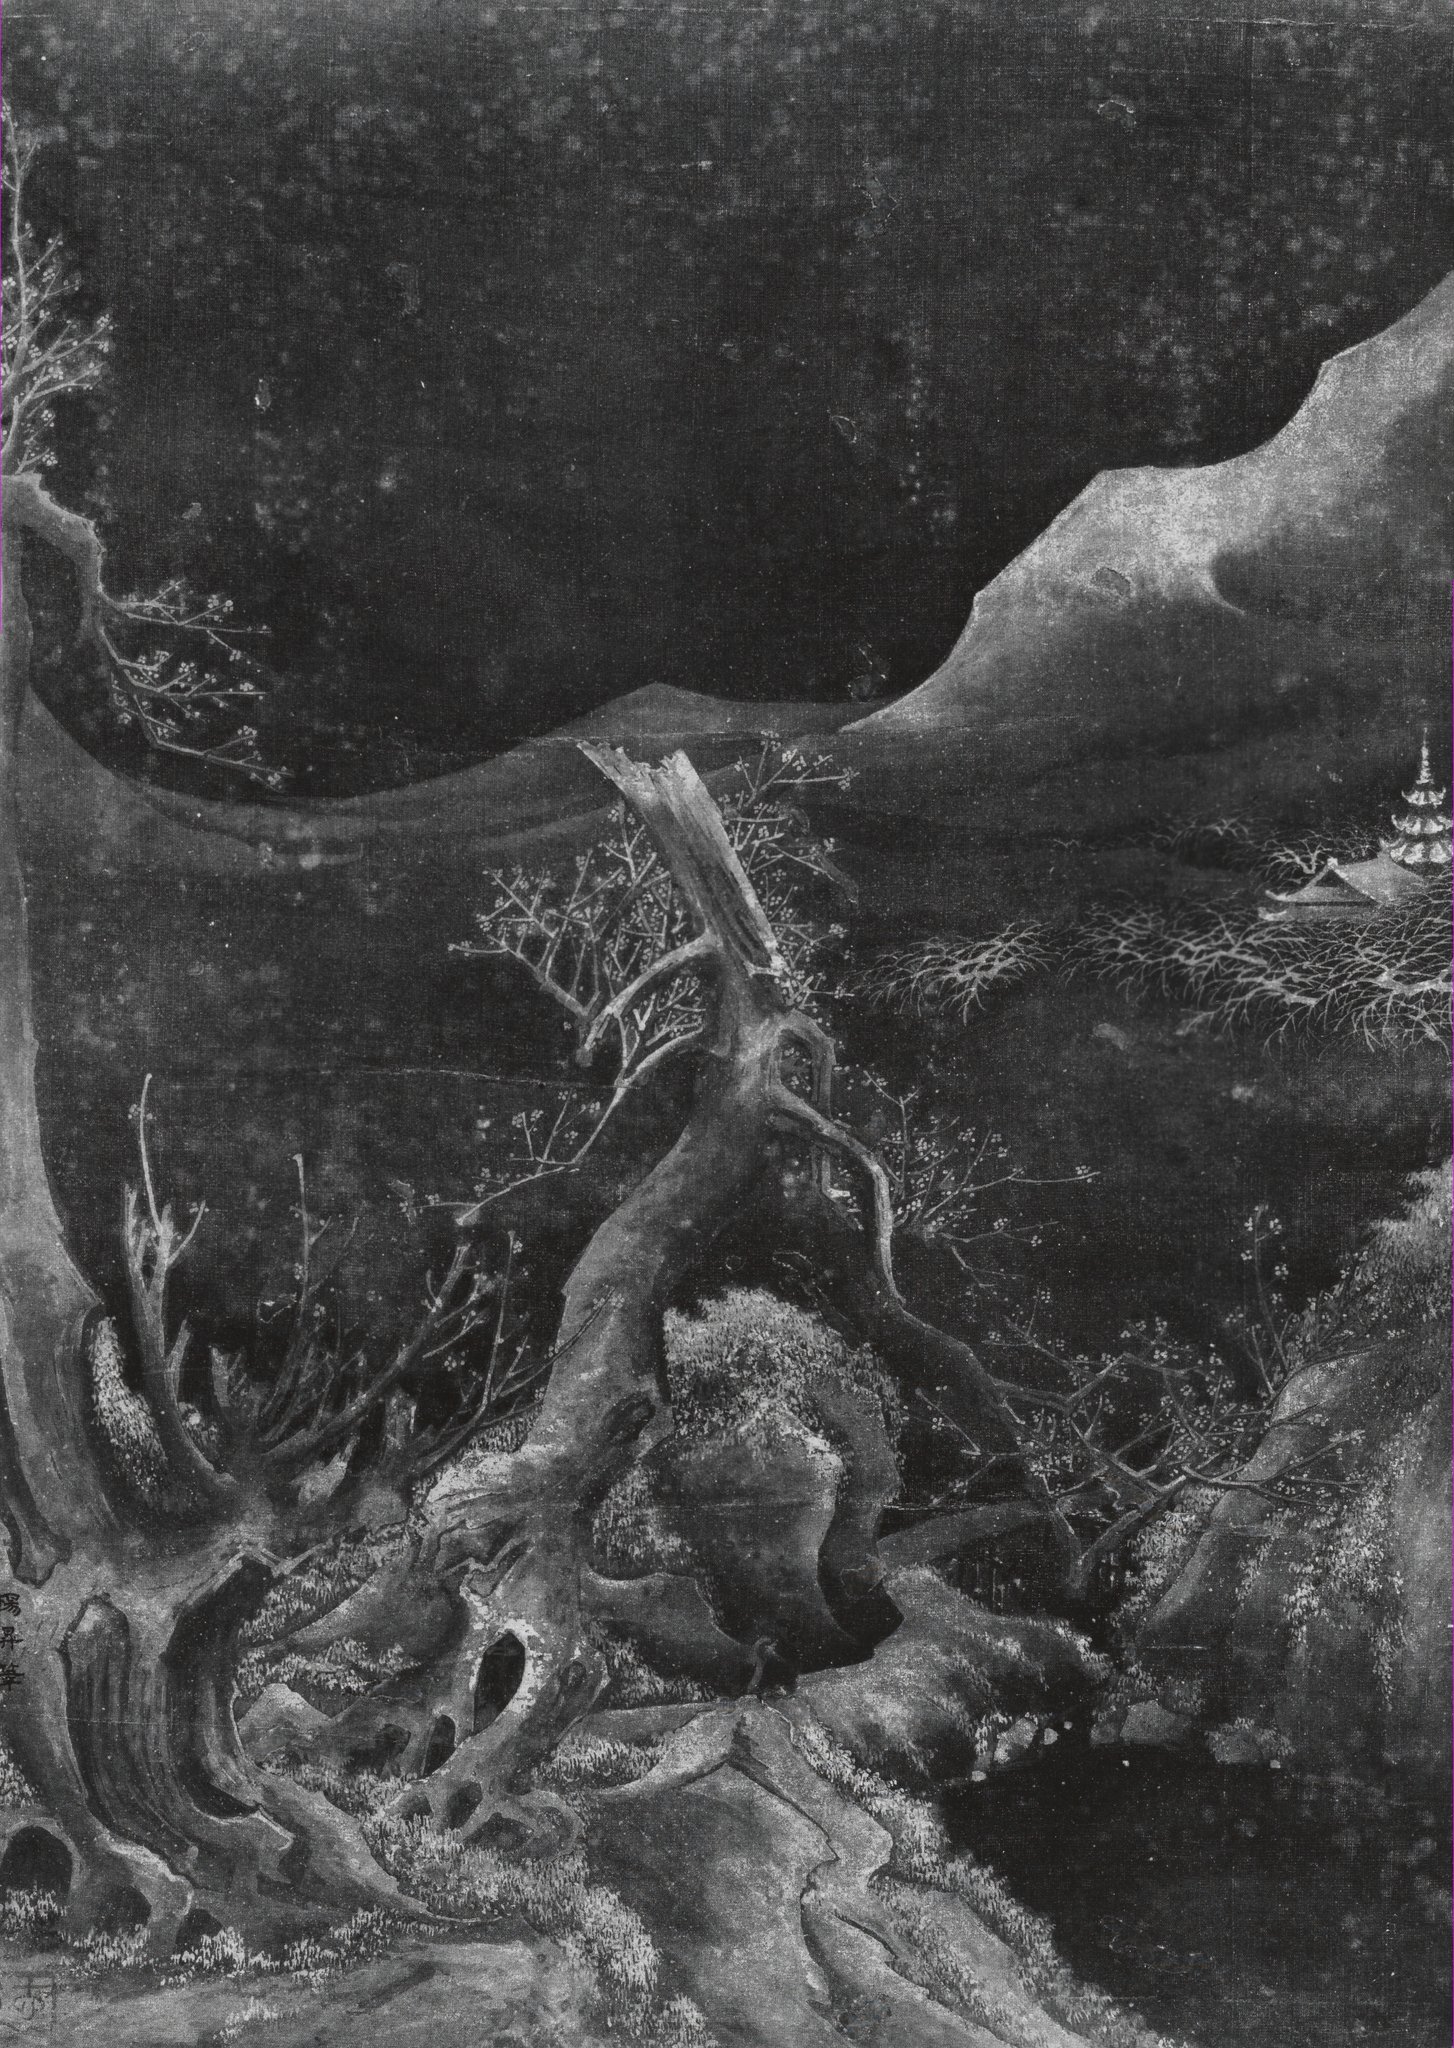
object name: hanging scroll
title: Landscape in the Tang Manner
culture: chinese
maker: unidentified artist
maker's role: artist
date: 1368-1644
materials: ink, silk